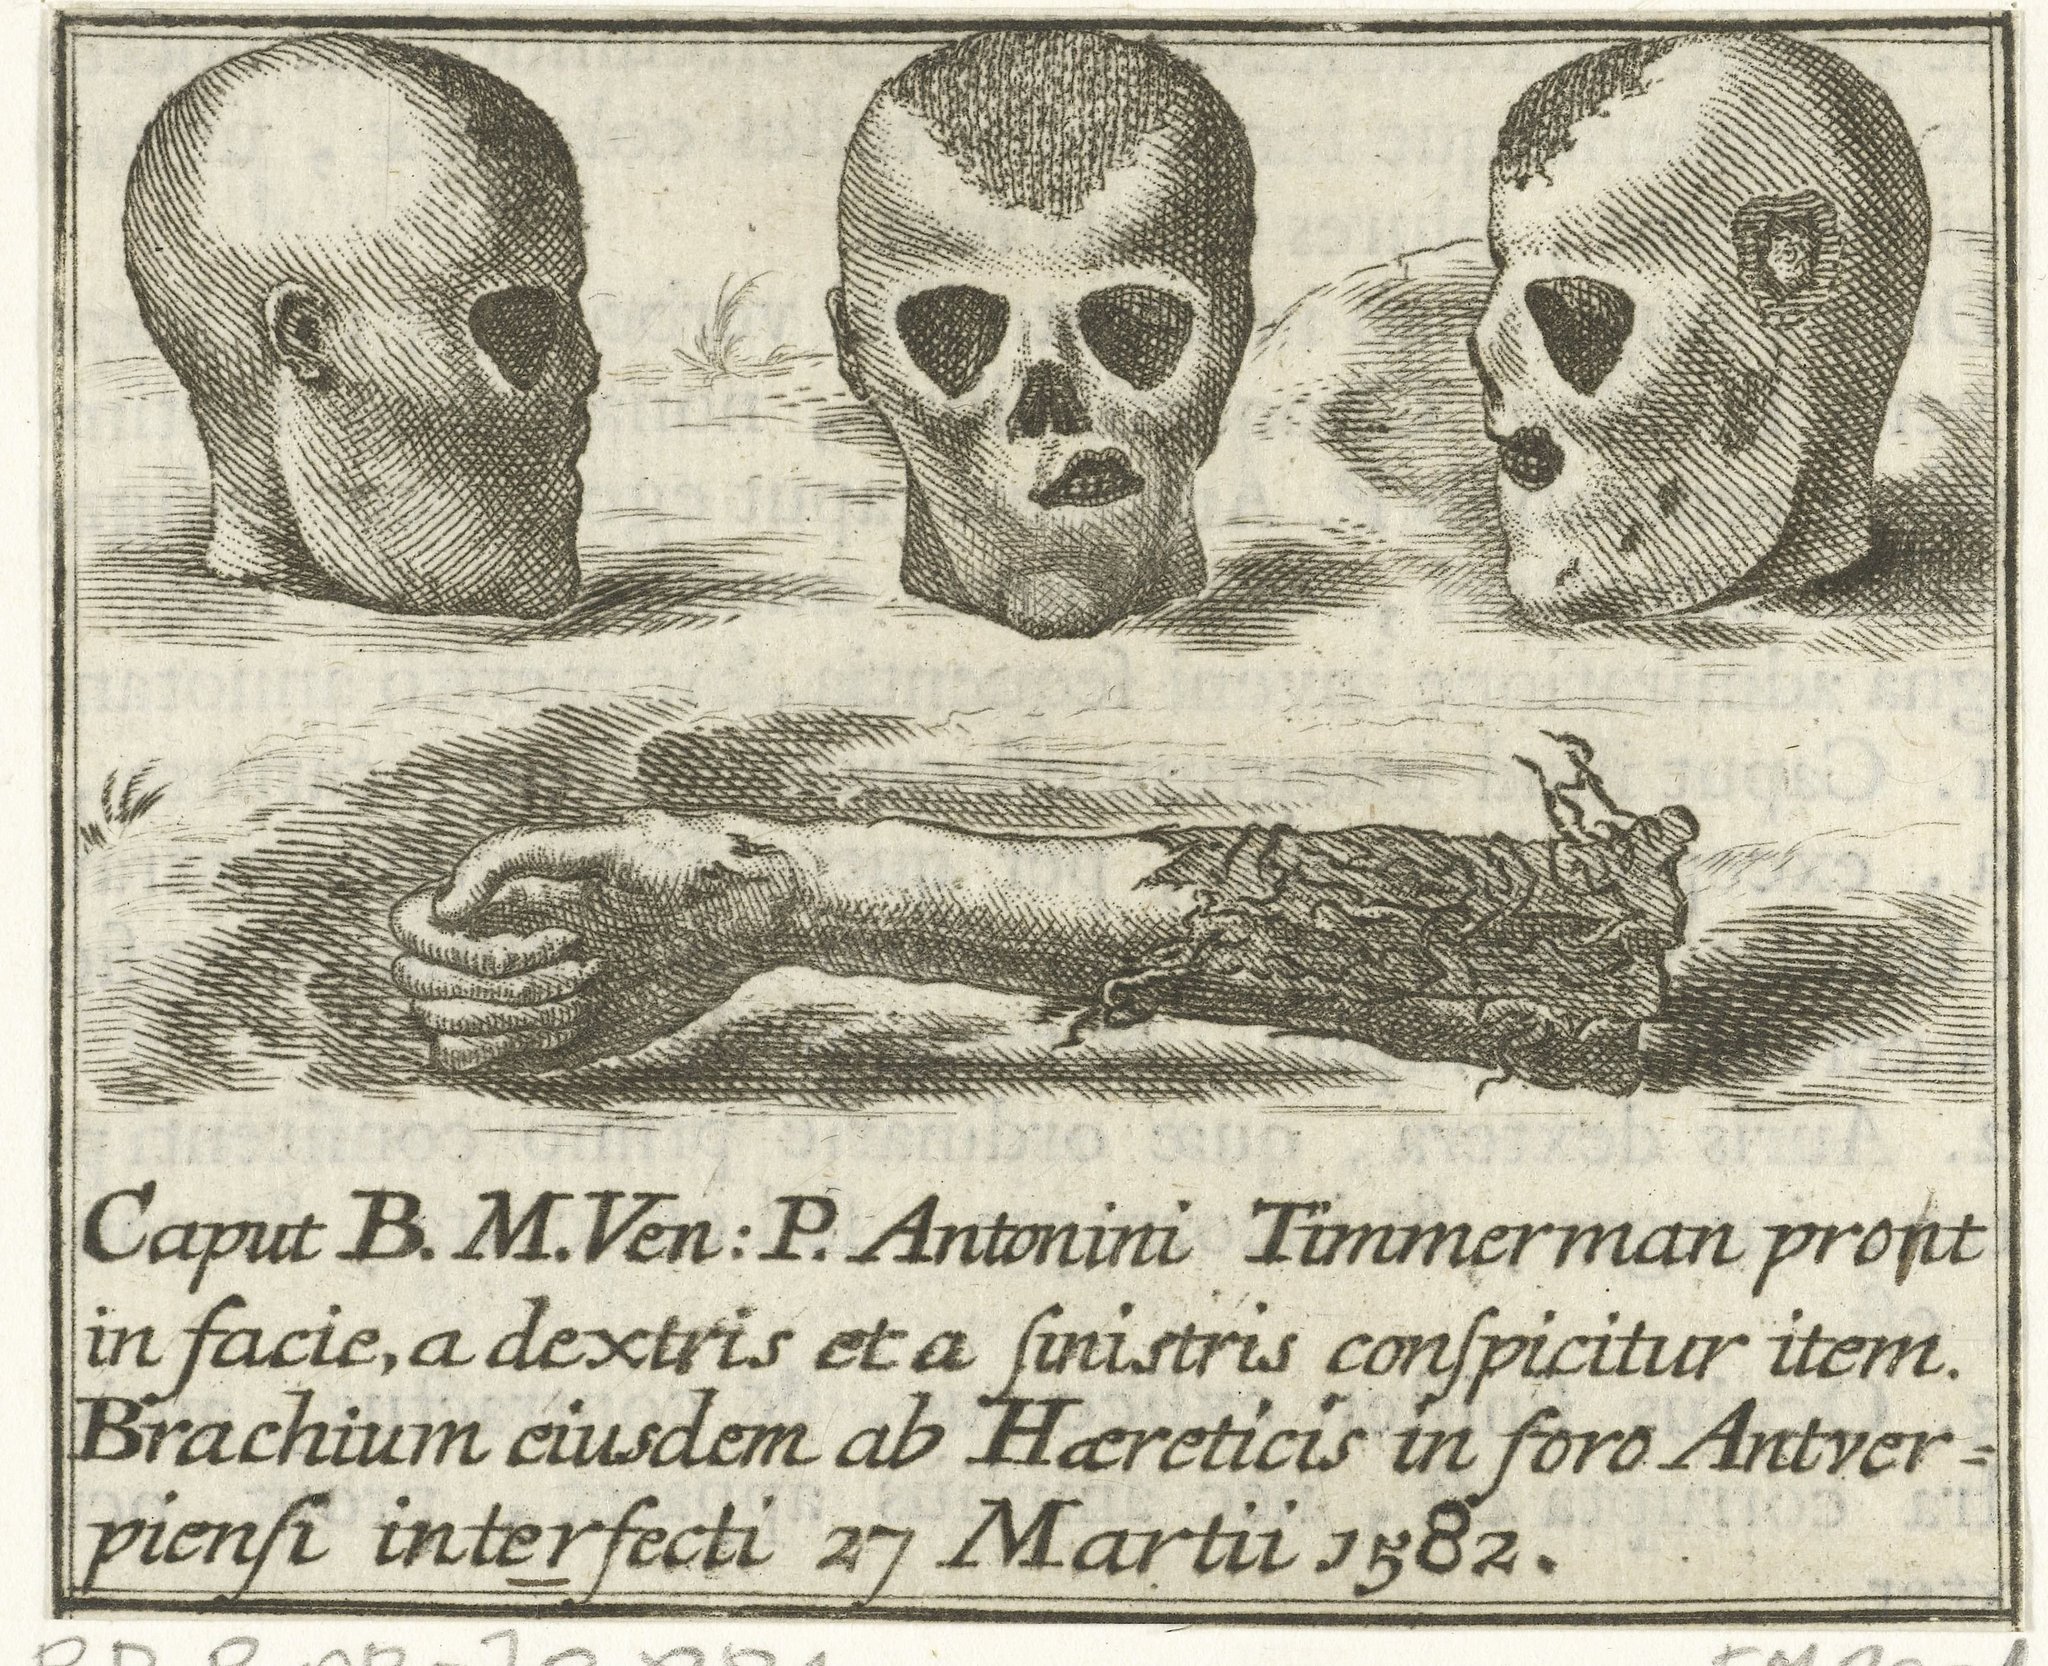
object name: history print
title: Hoofd en arm van Ant. Timmerman, medestander van Jean de Jauregui, gevonden in 1715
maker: Anonymous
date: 1715-1724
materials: paper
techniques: engraving, etching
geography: northern netherlands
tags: corpse preserved by natural causes, violent death, being killed; being mishandled and maltreated; seeking death (+ execution (by judicial verdict))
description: Het hoofd en de rechterarm van Ant. Timmerman, medestander van Jean de Jauregui terechtgesteld in 1582 te Antwerpen, bijna geheel onverteerd gevonden op 23 augustus 1715. Met onderschrift in het Latijn en bedrukt op achterzijde met tekst in het Latijn.